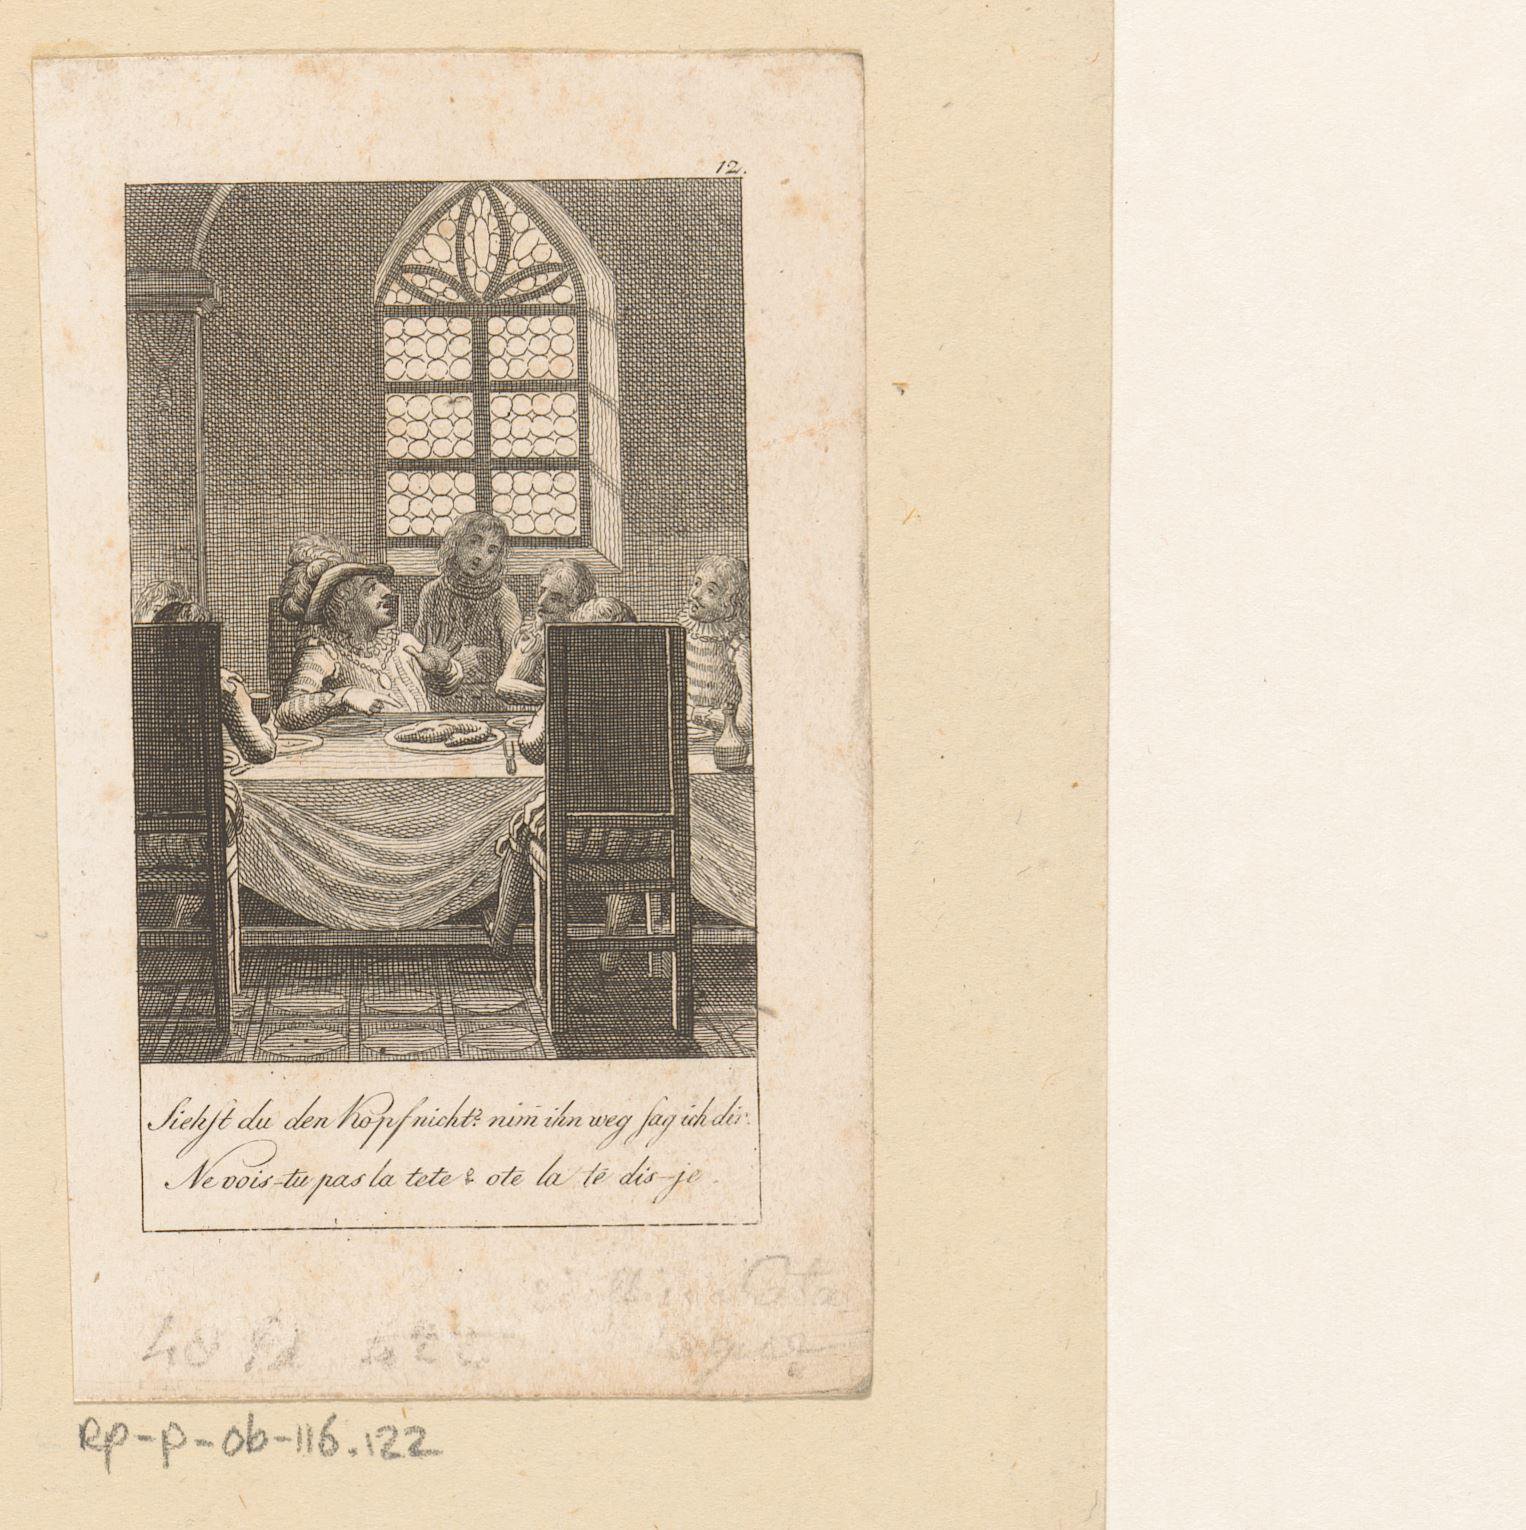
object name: print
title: Voorstelling uit de geschiedenis van de Nederlandse stadhouders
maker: christian gottlieb geyser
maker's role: print maker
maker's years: 1742-1803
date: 1796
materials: paper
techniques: etching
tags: history, evening meal, dinner, supper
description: Prent gebruikt voor: Geschichte der Statthalterschaft der Niederlande. Gotha: s.n., 1796.